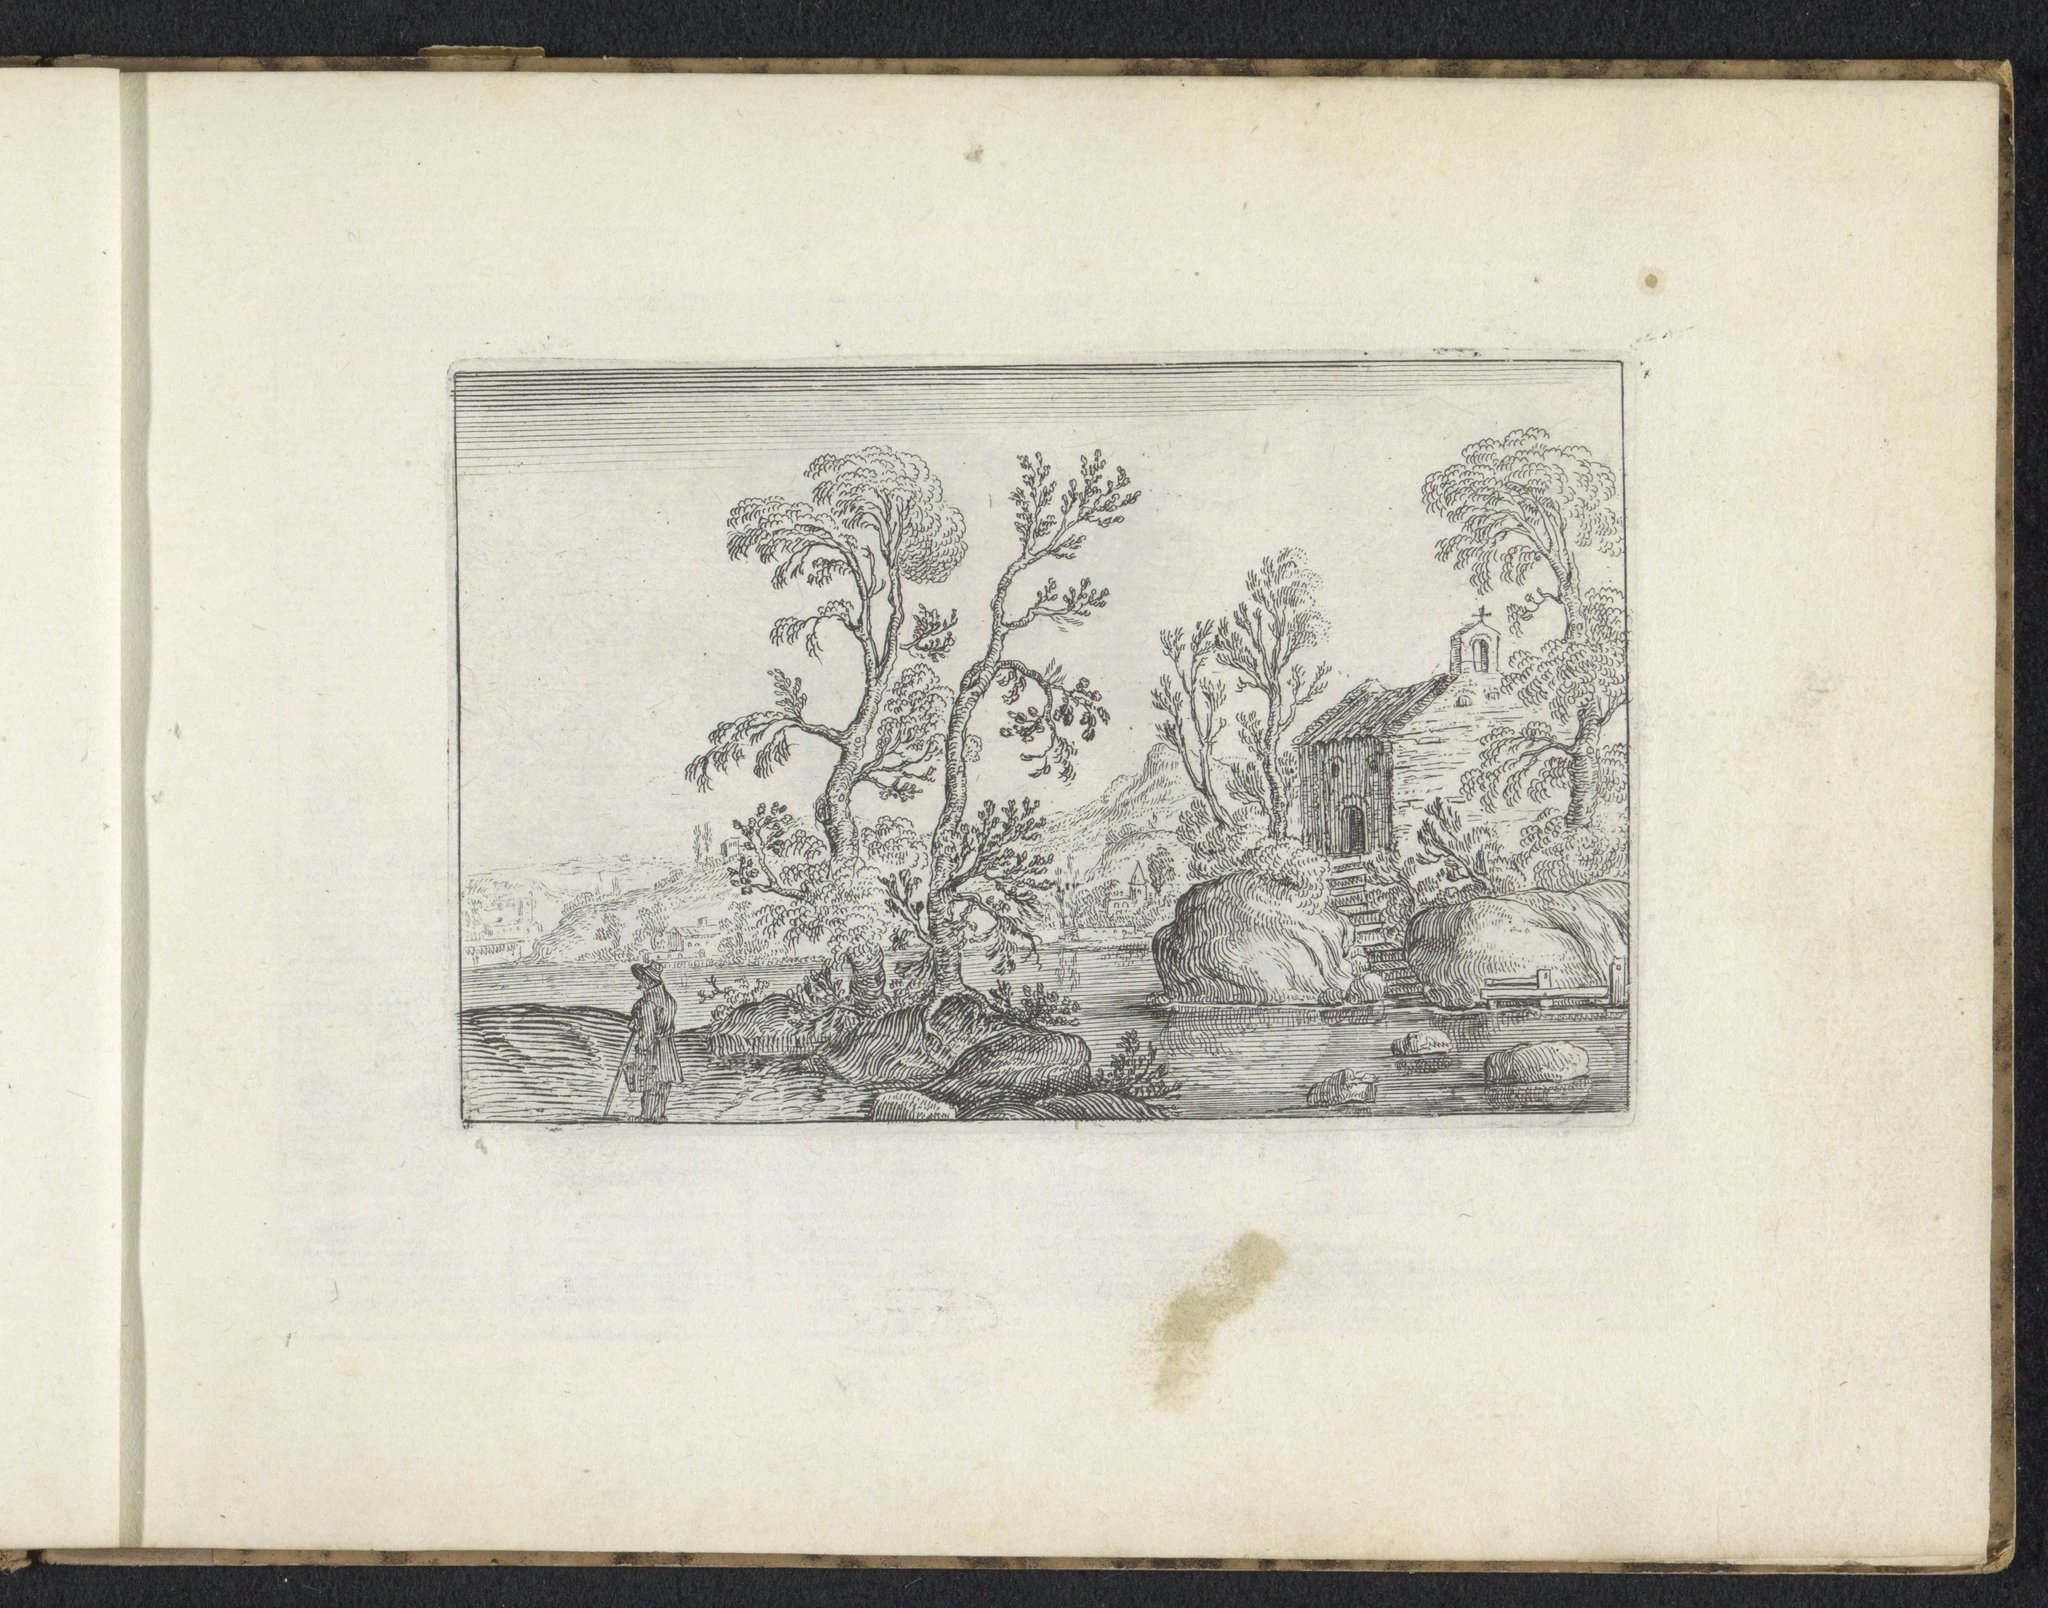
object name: album leaf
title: Landschap met een kapel aan het water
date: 1610-1638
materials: paper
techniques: etching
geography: northern netherlands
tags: city-view, and landscape with man-made constructions, landscapes, church (exterior) - qq - small church, chapel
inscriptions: collector's mark: Lugt 2228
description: Landschap met een rivier. Op de oever een trap naar een kapel. Links staat een man met een stok en een mand. De prent maakt deel uit van een album.